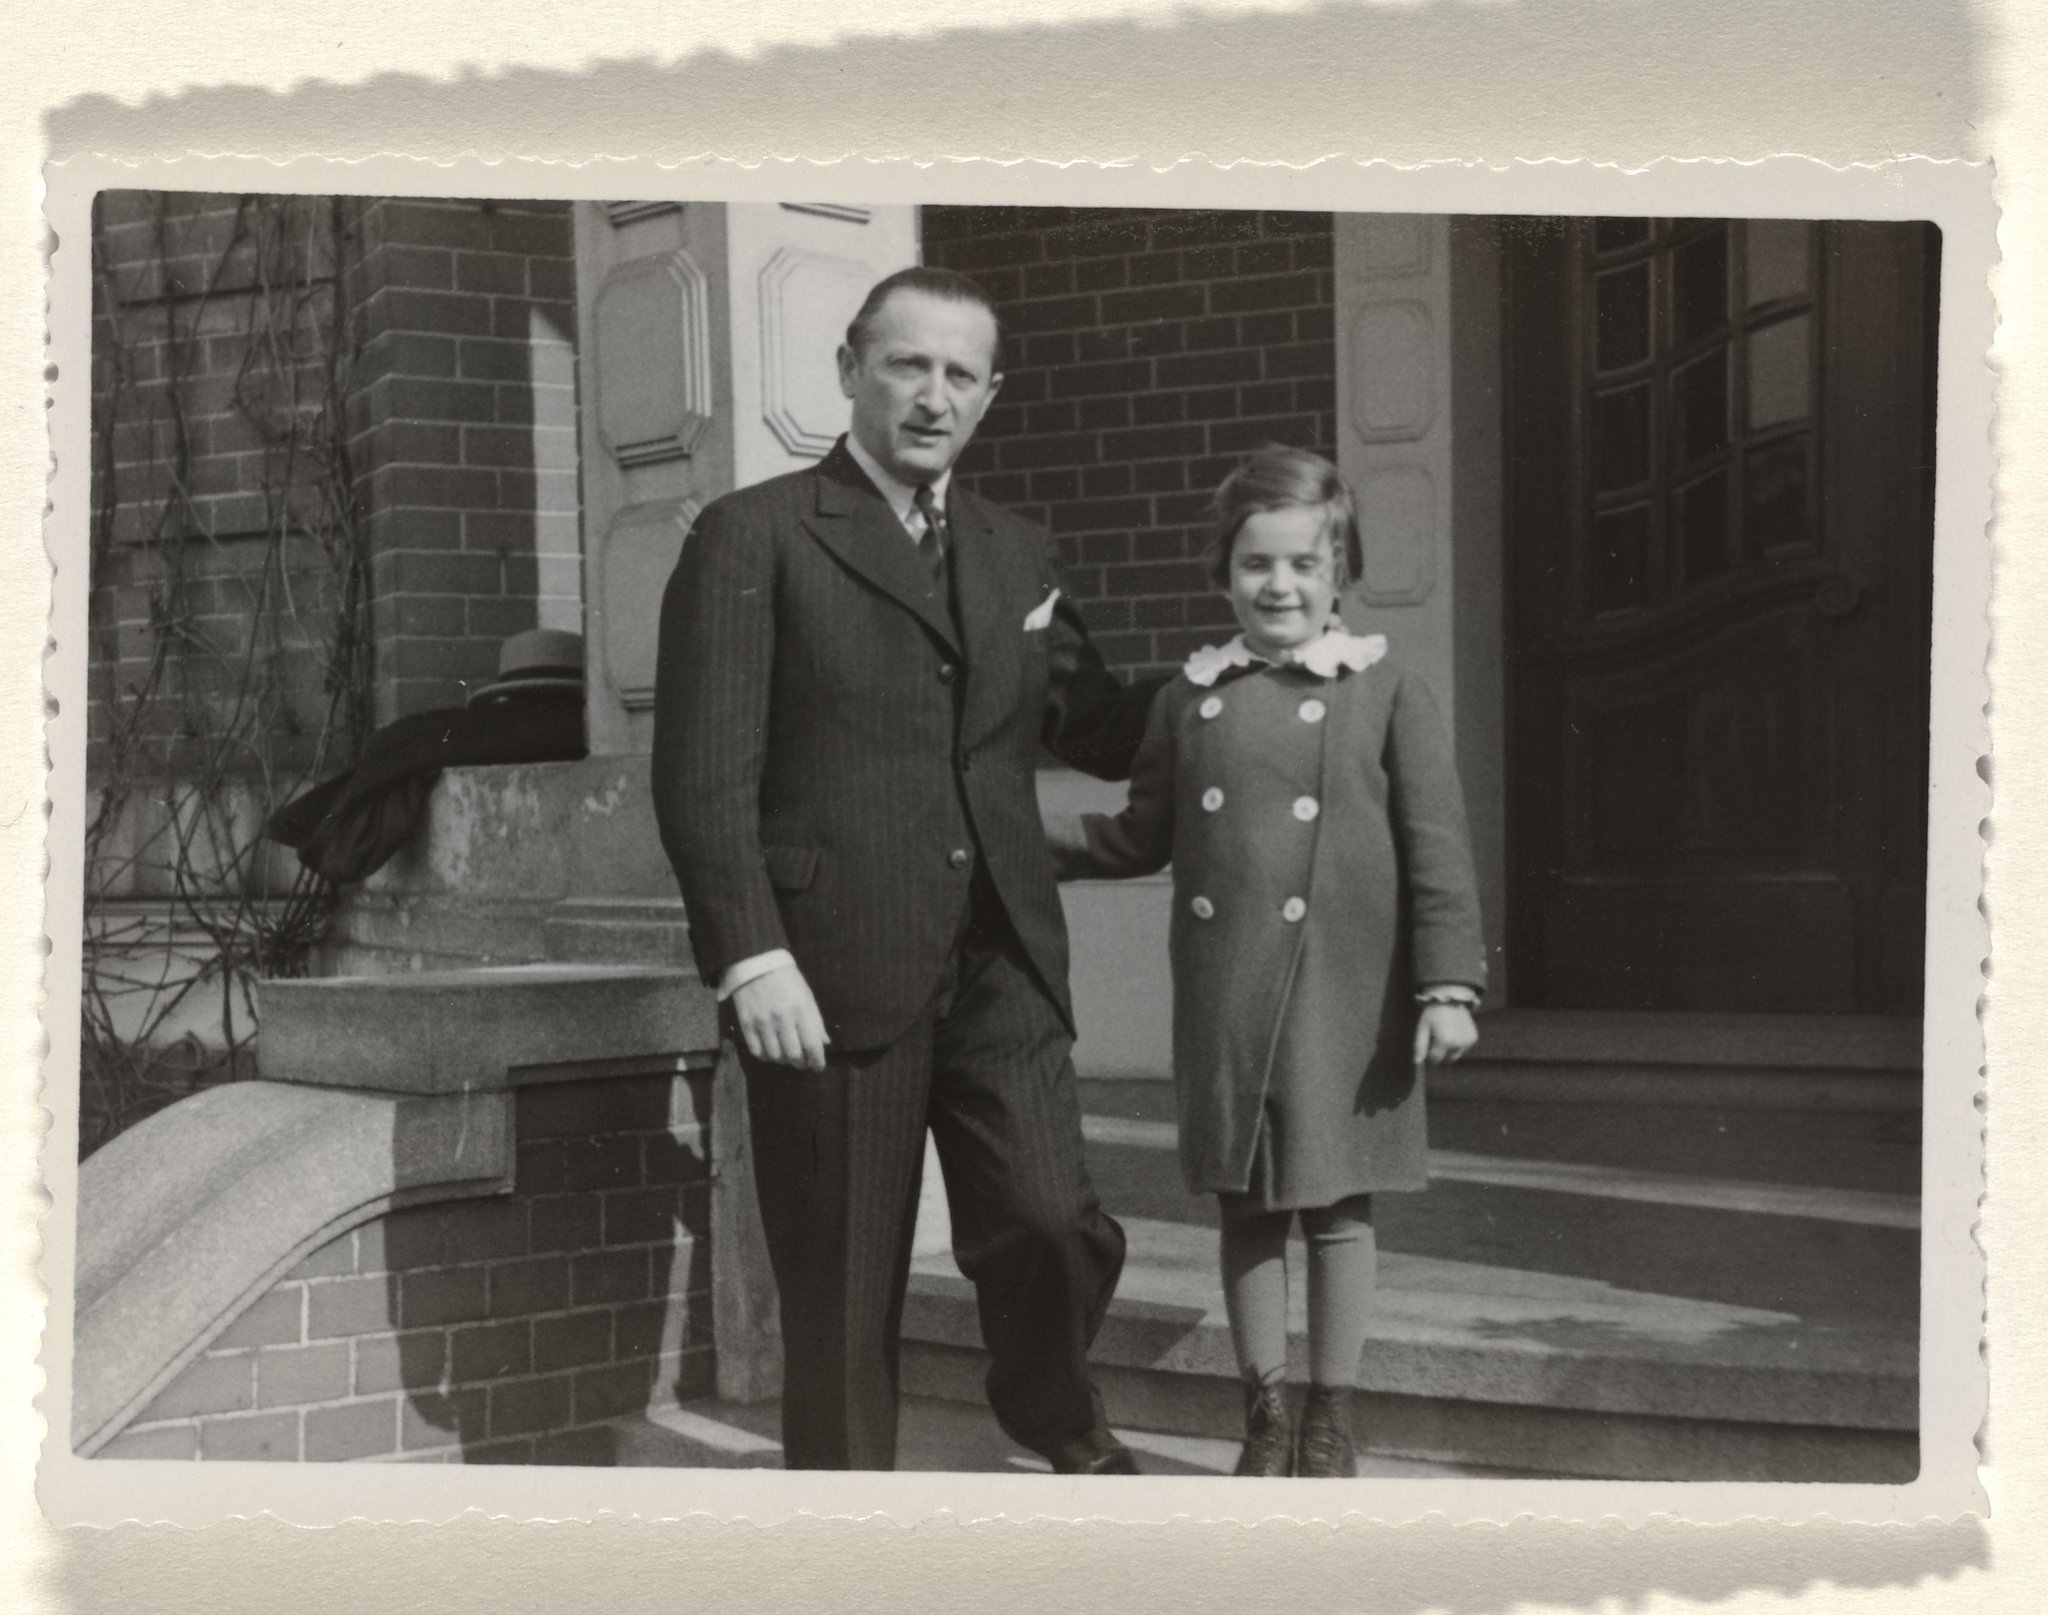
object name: photograph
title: Isabel Wachenheimer en Willy Moos, september 1934, Hamburg, Bellevue 62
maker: Anonymous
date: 1909-1934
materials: photographic support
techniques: gelatin silver print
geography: hamburg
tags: leiden, isabel wachenheimer-elon, willy moos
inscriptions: date: ‘Sept.34.’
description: Dit object is onderdeel van de nalatenschap van Isabel Elon-Wachenheimer (1928-2010). Tot haar overlijden behoorde het samen met de andere objecten uit de nalatenschap tot haar privédomein van Isabel Wachenheimer. In die particuliere context zijn deze objecten tezamen en individueel aandenkens - aan de jeugd, ouders en familie van Isabel Wachenheimer vóór en tijdens de Shoah en aan haar leven na de Tweede Wereldoorlog. Isabel Wachenheimer, die van juni 1943 tot mei 1945 gevangen zat in Kamp Westerbork, Theresienstadt, Auschwitz, Lenzing a/d Oberdonau (een buitenkamp van Mauthausen), overleefde de Shoah. Haar ouders – Eugène Wachenheimer en Else Wachenheimer-Moos - werden op 14 oktober 1944 in Auschwitz-Birkenau vermoord.